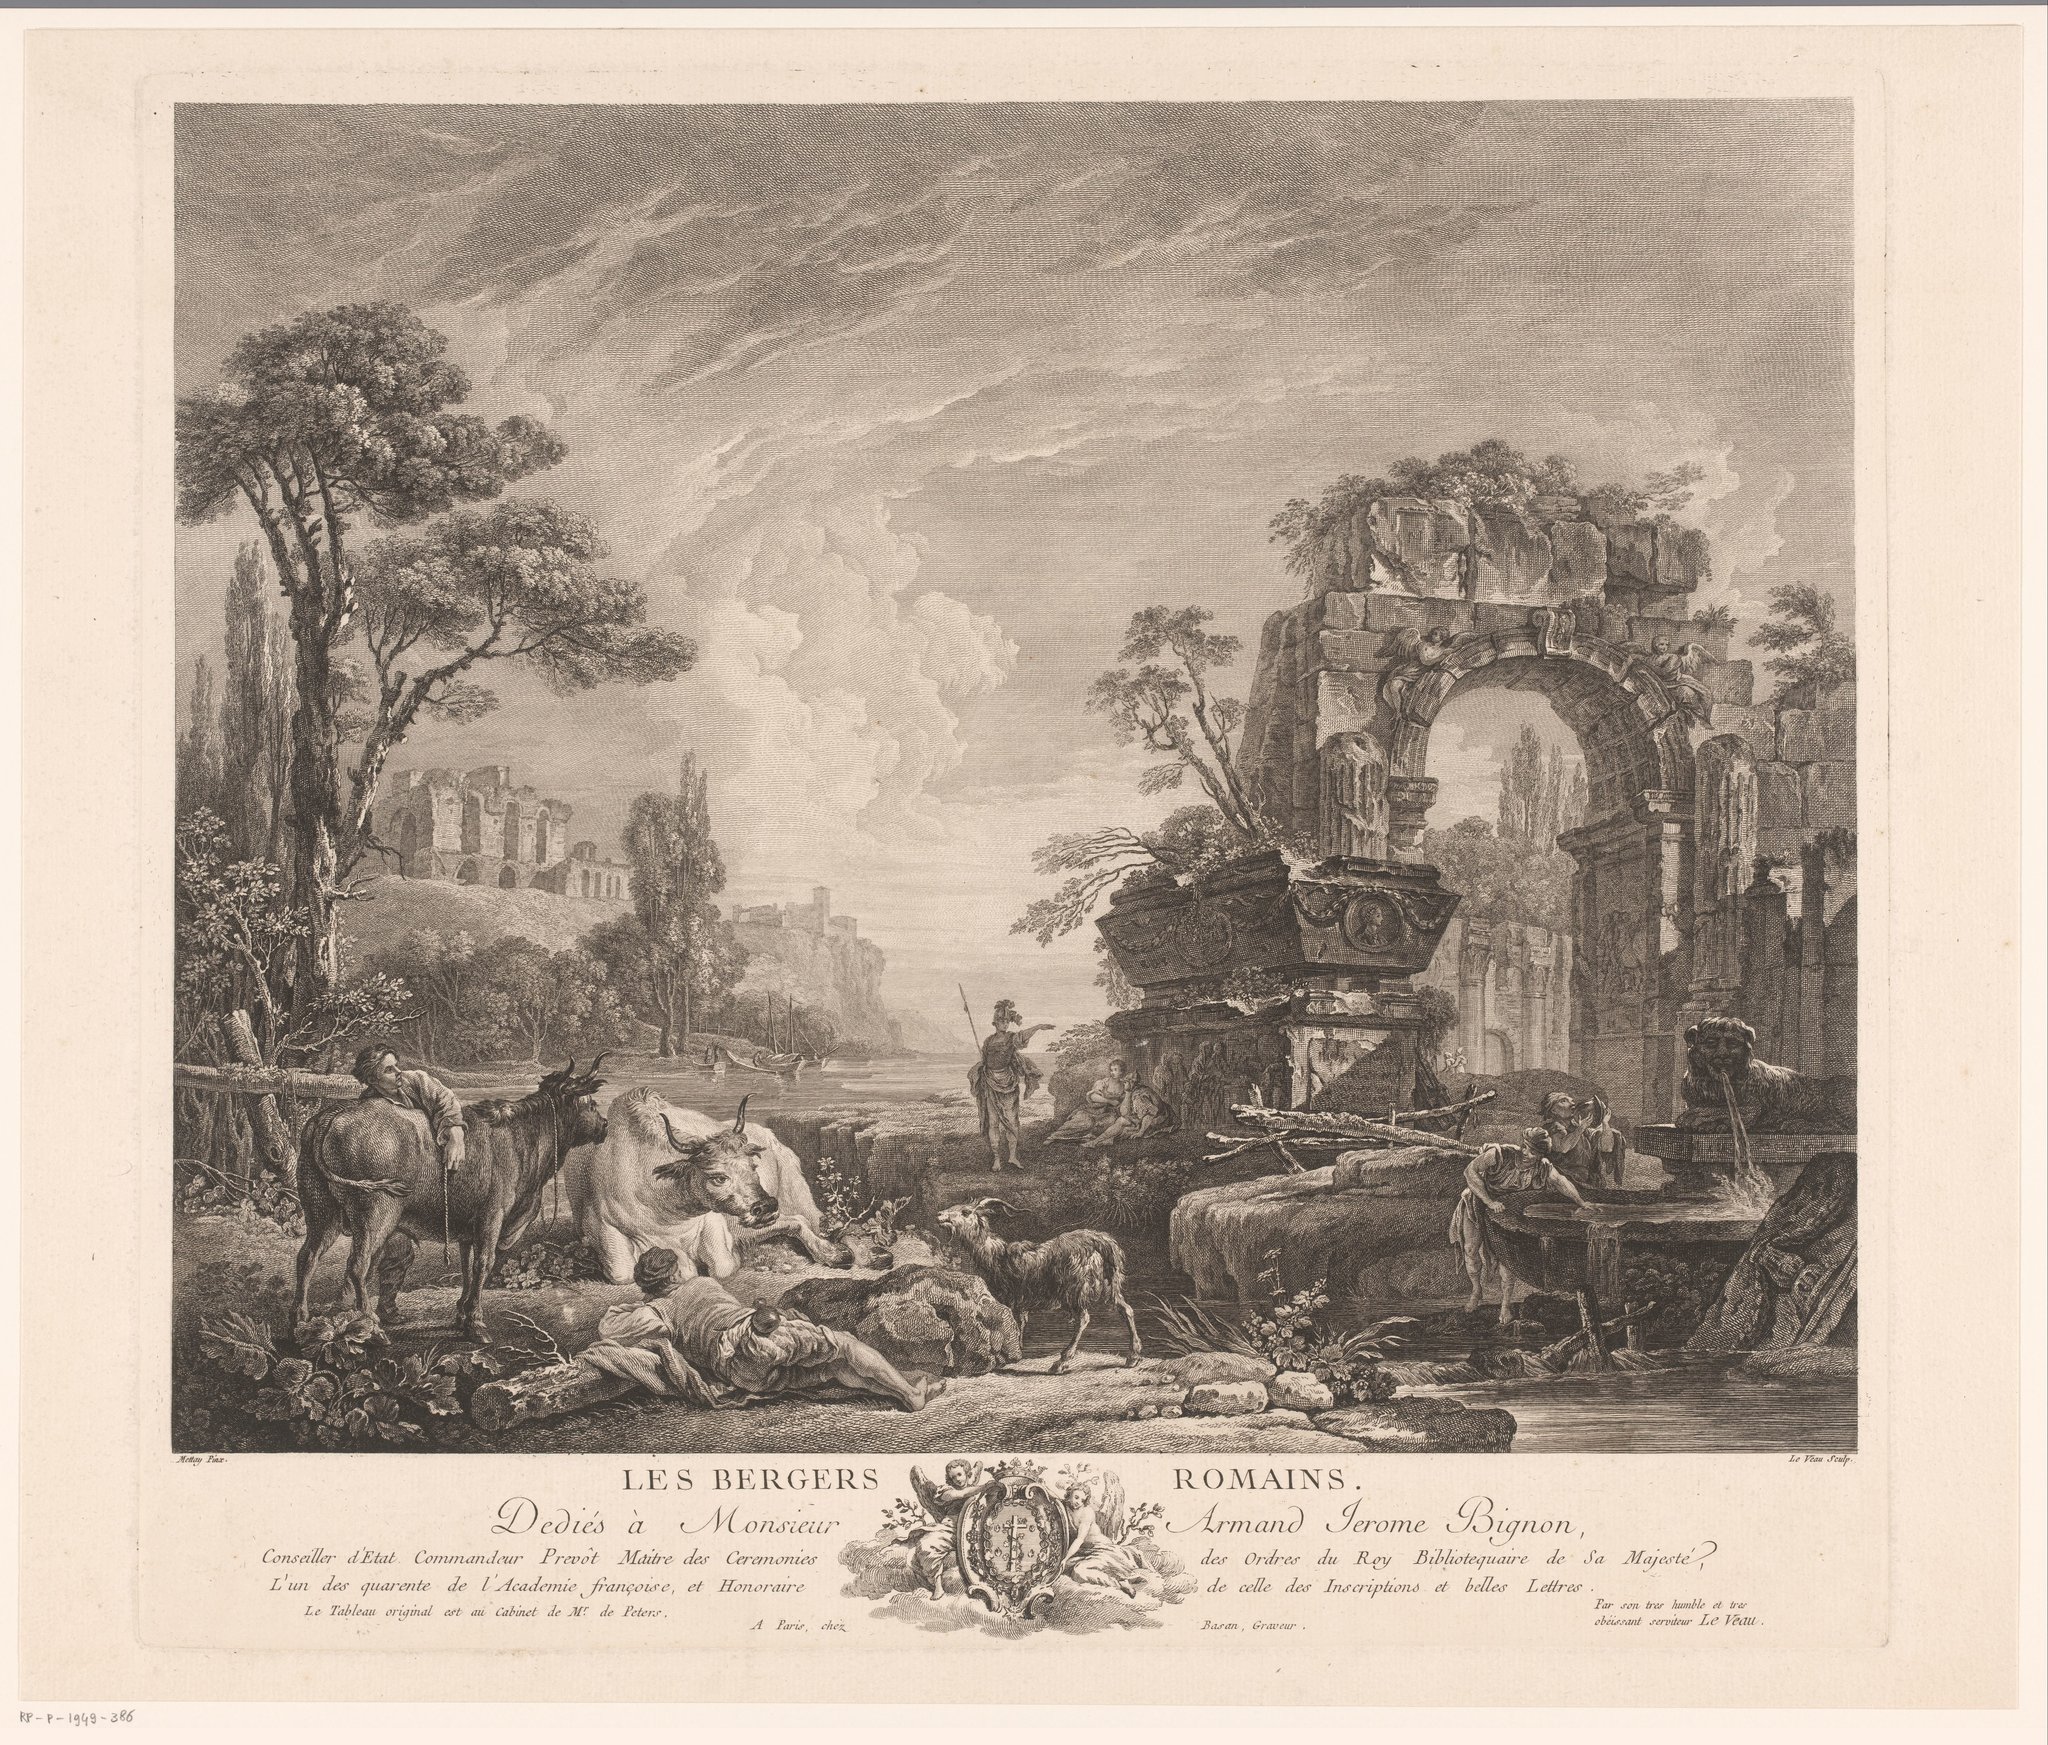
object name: print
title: Herders en reizigers bij een fontein in een landschap met ruïnes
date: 1739-1786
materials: paper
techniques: engraving, etching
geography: france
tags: herding, herdsman, herdswoman, shepherd, shepherdess, cowherd, etc., landscape with ruins, utilitarian, public pump or water fountain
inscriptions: collector's mark: Lugt 2228